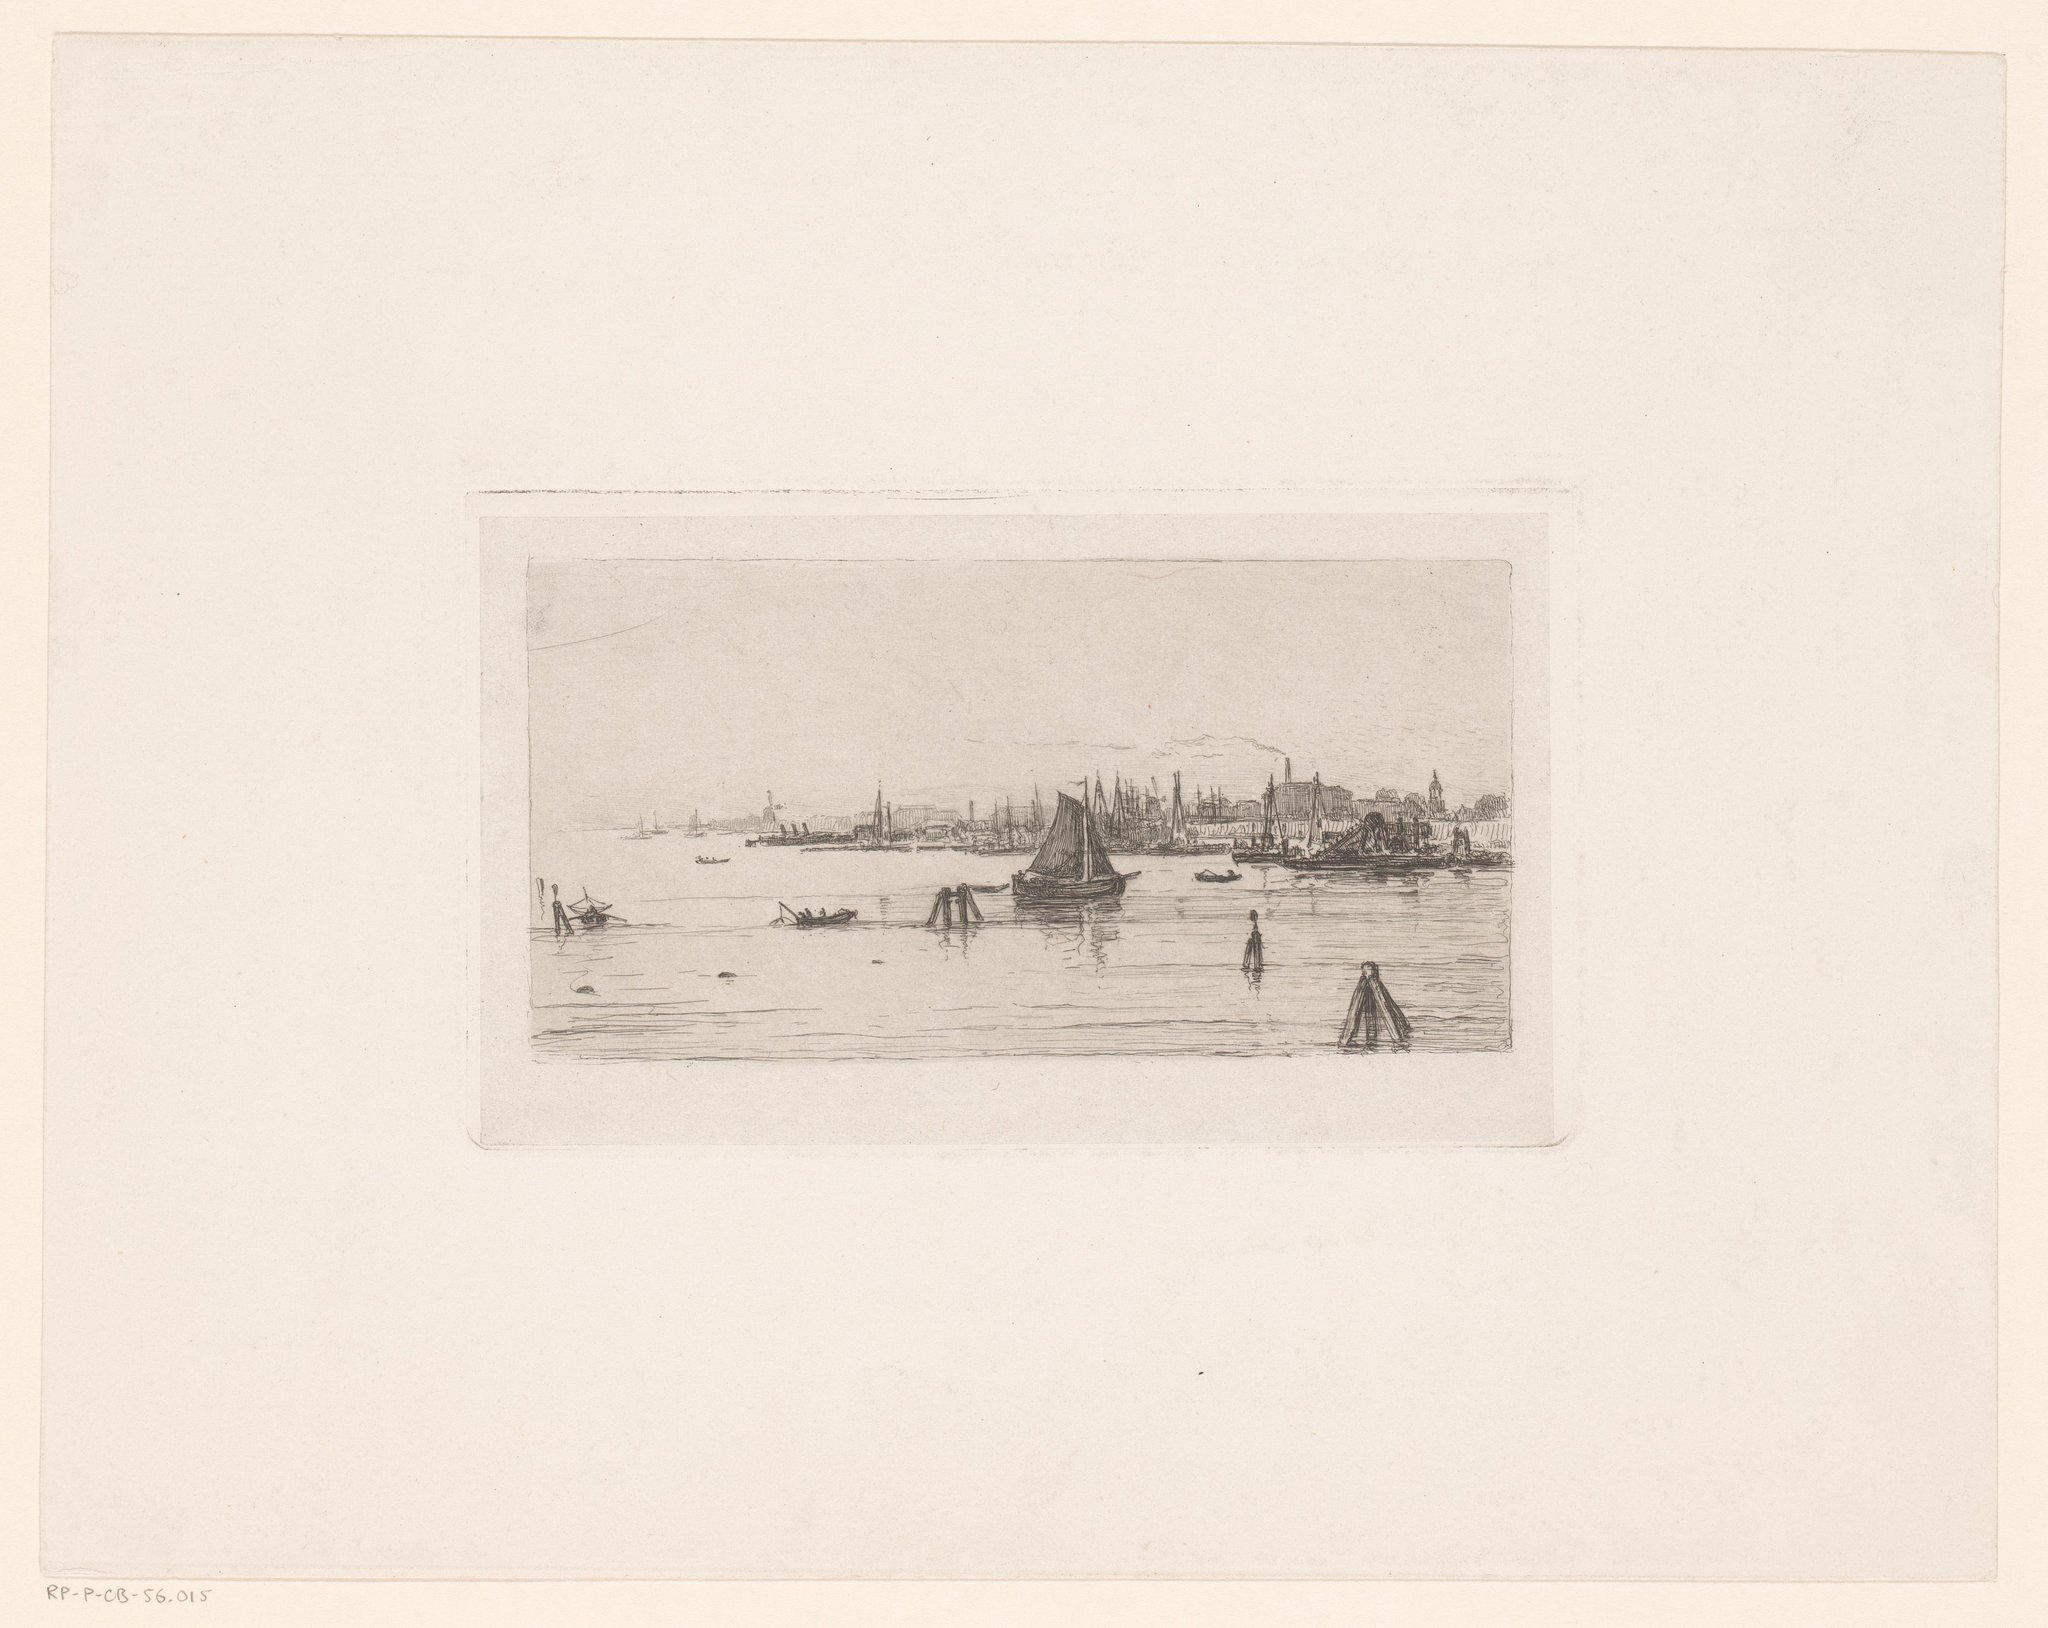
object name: print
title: Gezicht op een haven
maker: william unger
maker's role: draughtsman, painter, print maker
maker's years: 1837-1932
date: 1847-1932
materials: paper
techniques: etching, intaglio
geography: germany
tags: harbour, sailing-ship, sailing-boat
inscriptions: collector's mark: Lugt 2228